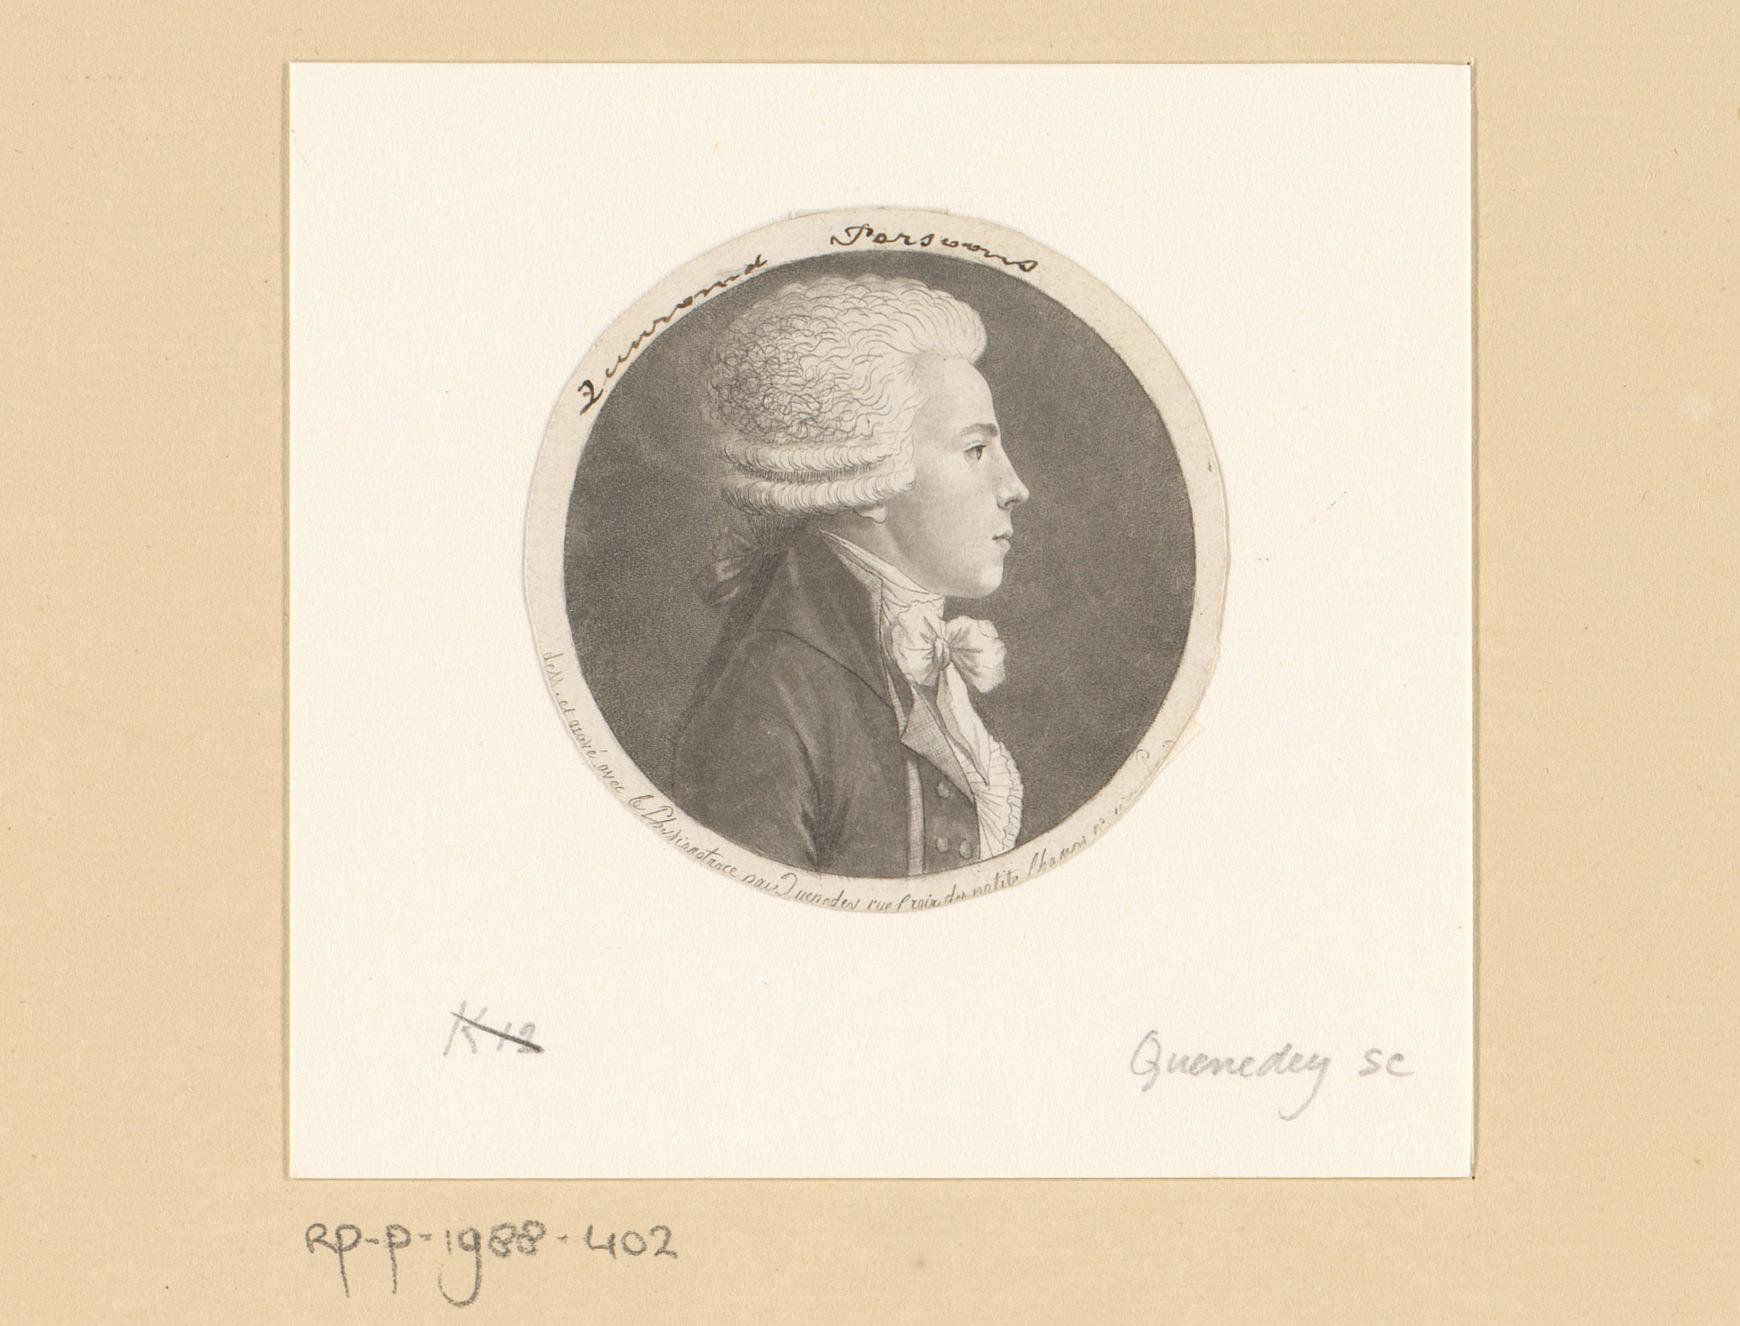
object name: physionotrace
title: Portret van Frans Adriaan Zuurmont Persoons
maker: edme quenedey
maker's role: print maker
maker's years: 1756-1830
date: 1785-1830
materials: paper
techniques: aquatint, etching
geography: paris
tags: silhouette-apparatus, 'physionotrace', anonymous historical person portrayed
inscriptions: collector's mark: Lugt 2228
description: Deze prent heeft het nummer L.12 in het fonds van Quenedey.